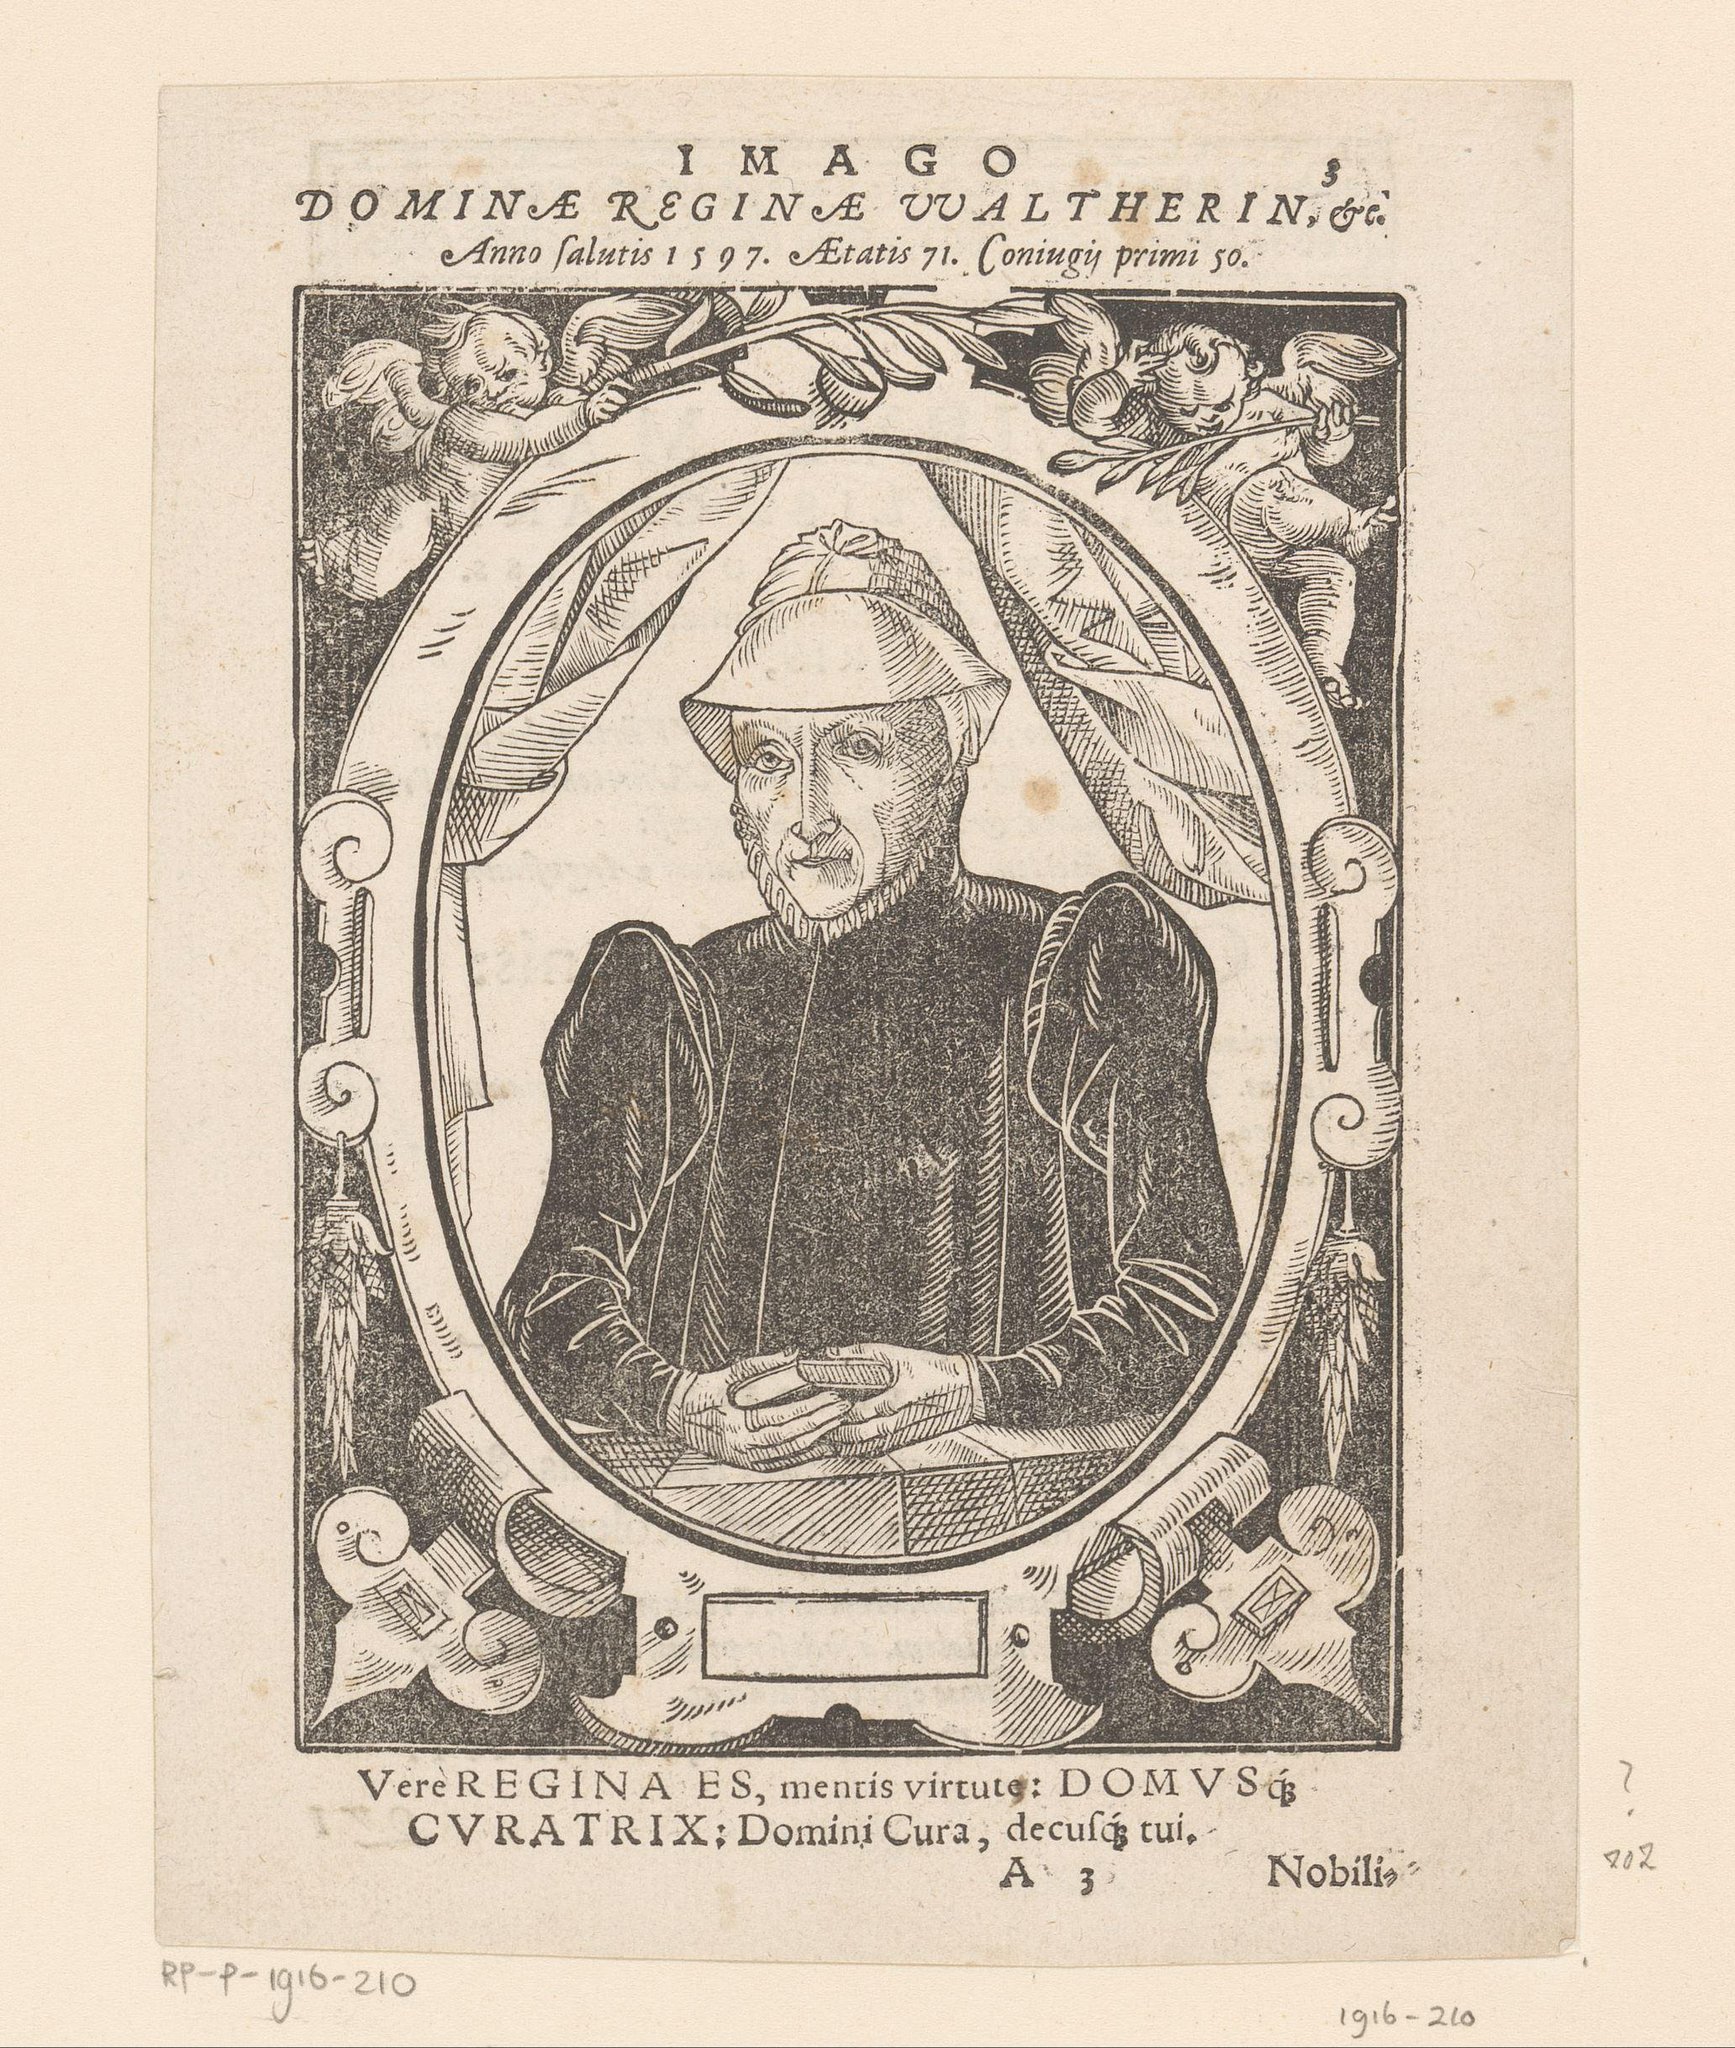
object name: book illustration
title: Portret van Regina Varnbüler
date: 1597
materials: paper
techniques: woodcut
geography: tübingen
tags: historical persons - bb - woman, book, cupids: 'amores', 'amoretti', 'putti'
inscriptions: collector's mark: Lugt 2228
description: Prent mogelijk gebruikt voor de publicatie: Cellius, Erhard. Imagines professorum Tubingensium. Tübingen: Erhard Cellius, 1596. Dit exemplaar is afkomstig uit een latere uitgave.